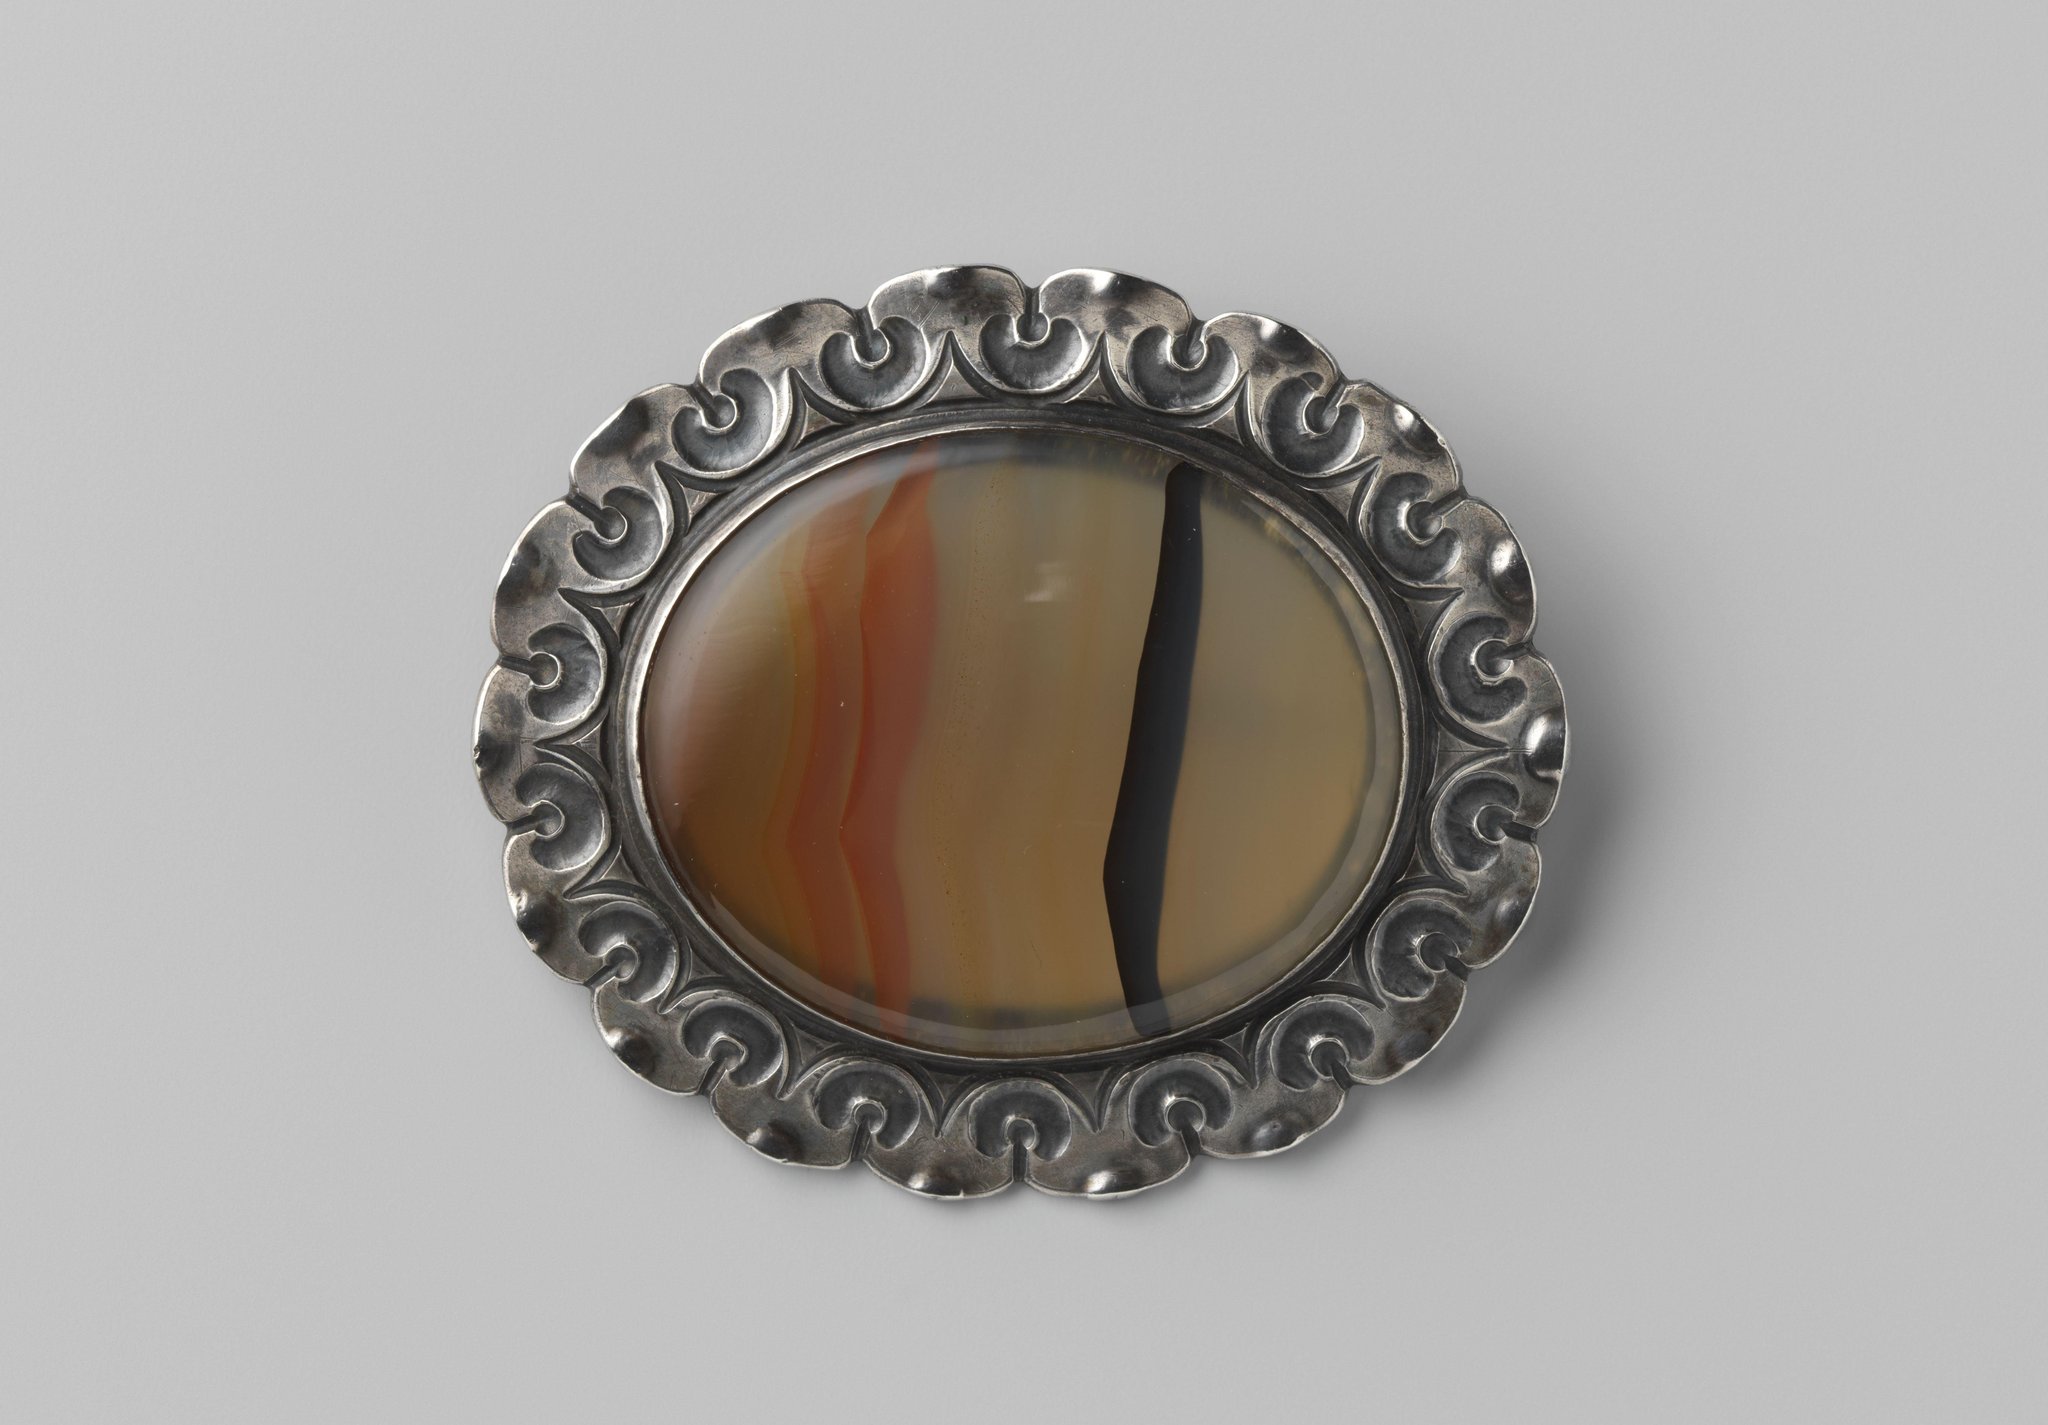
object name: brooch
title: Ovale broche van zilver en streepagaat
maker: Anonymous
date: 1930-1940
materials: stone, silver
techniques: grinding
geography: netherlands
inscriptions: : ‘I’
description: Ovale broche van zilver en cabochon geslepen streepagaat voorzien van een haaksluiting. De agaath is gevat in een geschulpte rand van zilver.